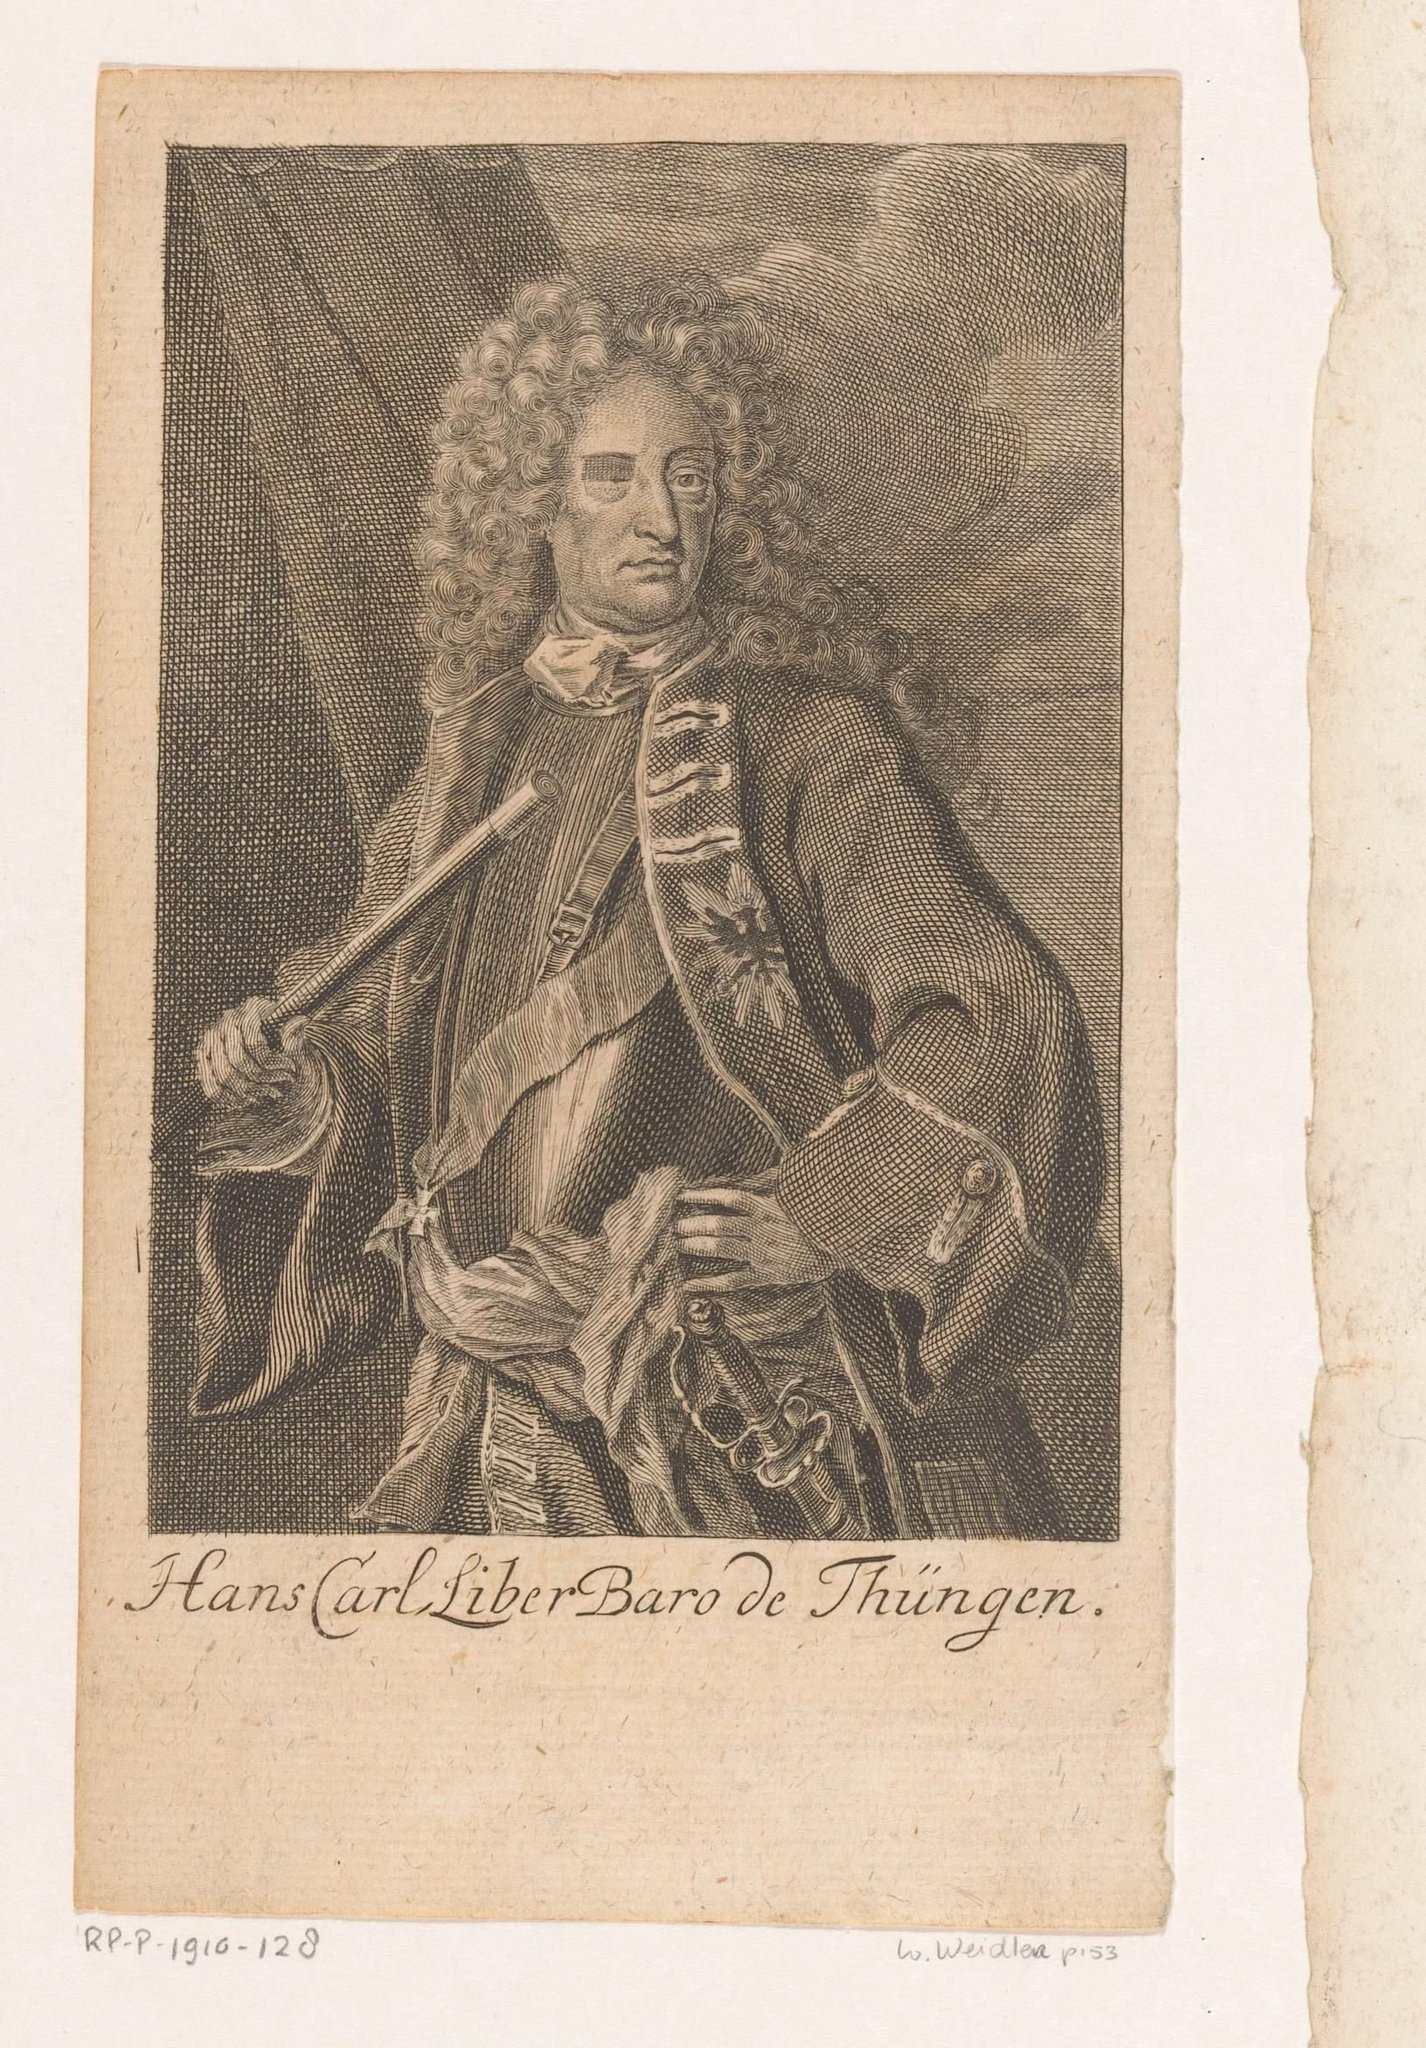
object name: print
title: Portret van Johann Carl von Thüngen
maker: martin bernigeroth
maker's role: print maker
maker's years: 1670-1733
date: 1705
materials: paper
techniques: engraving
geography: leipzig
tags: armour, historical persons, baton of general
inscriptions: collector's mark: Lugt 2228